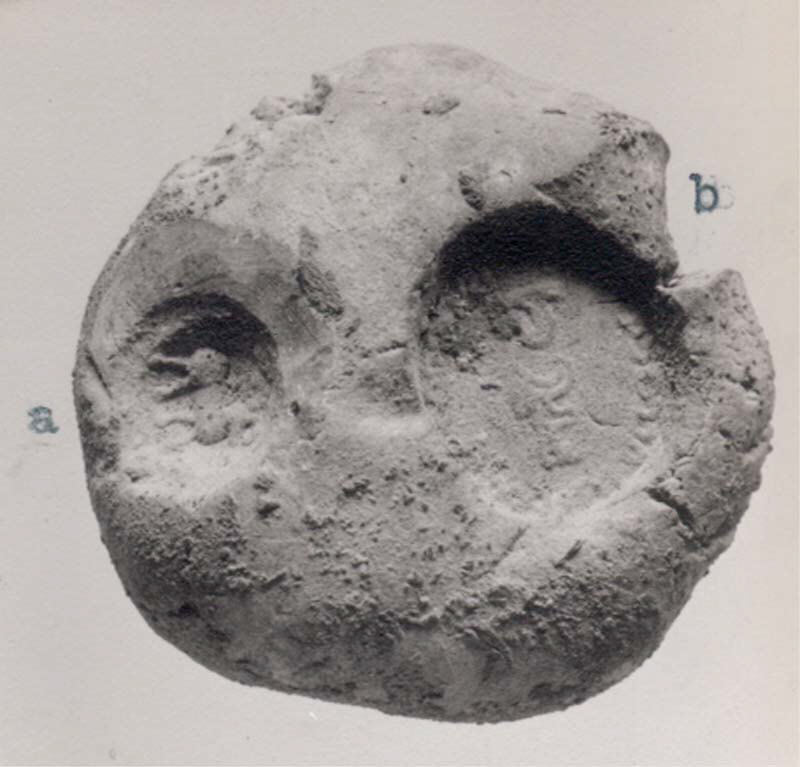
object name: sealing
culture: sasanian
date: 601-700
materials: clay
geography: iran